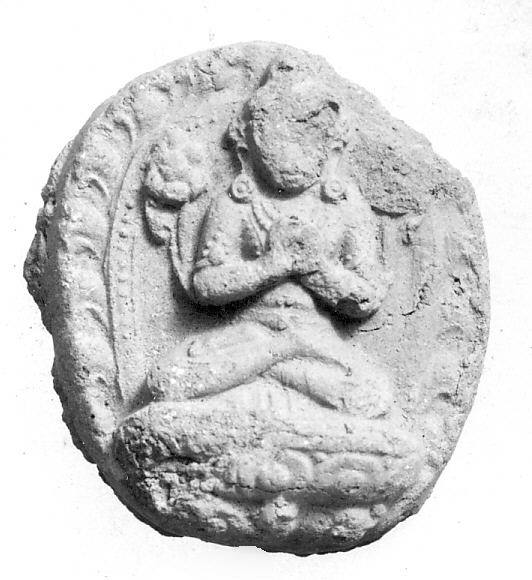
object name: plaque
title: Votive Plaque with Manjushri(?)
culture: tibetan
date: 1401-1700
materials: clay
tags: manjushri